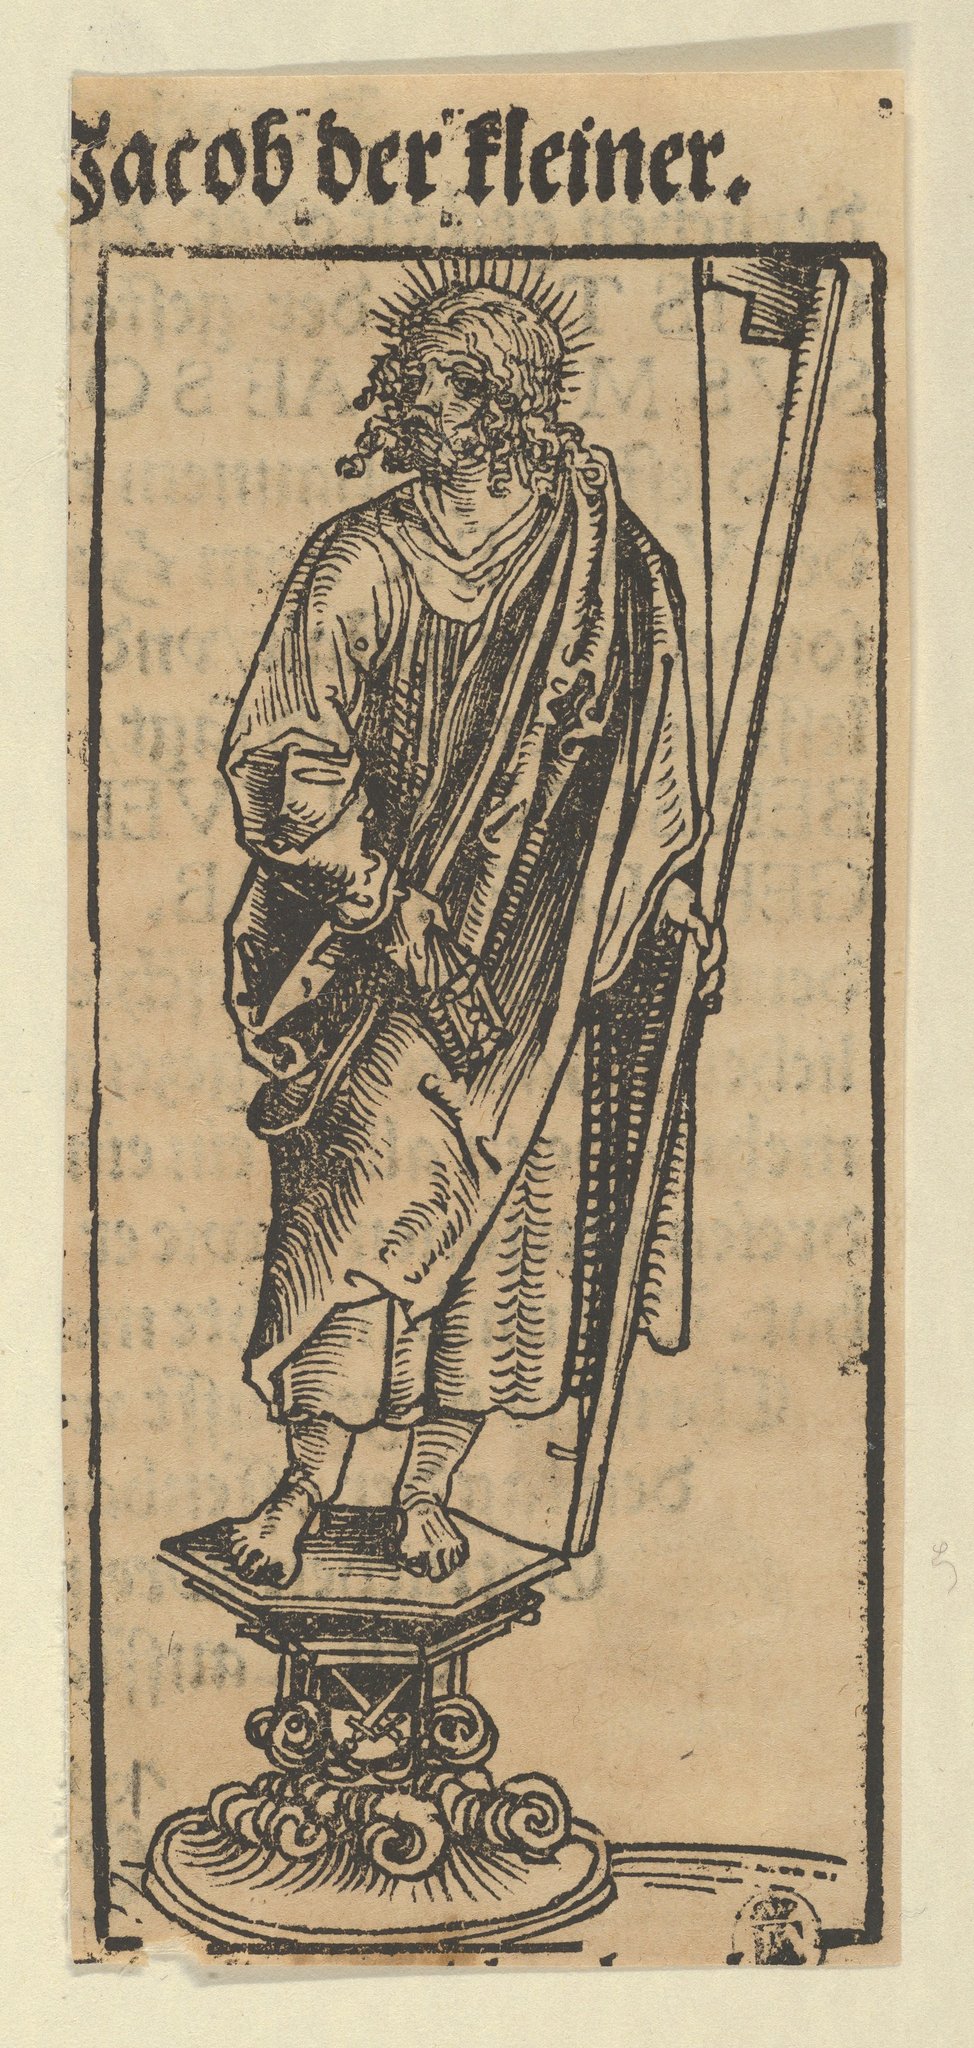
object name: print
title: Silver Statuette of St. James the Less, from the "Wittenberg Reliquaries"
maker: lucas cranach the elder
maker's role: artist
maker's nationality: german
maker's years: 1472-1553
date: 1472-1553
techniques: woodcut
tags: men,saints